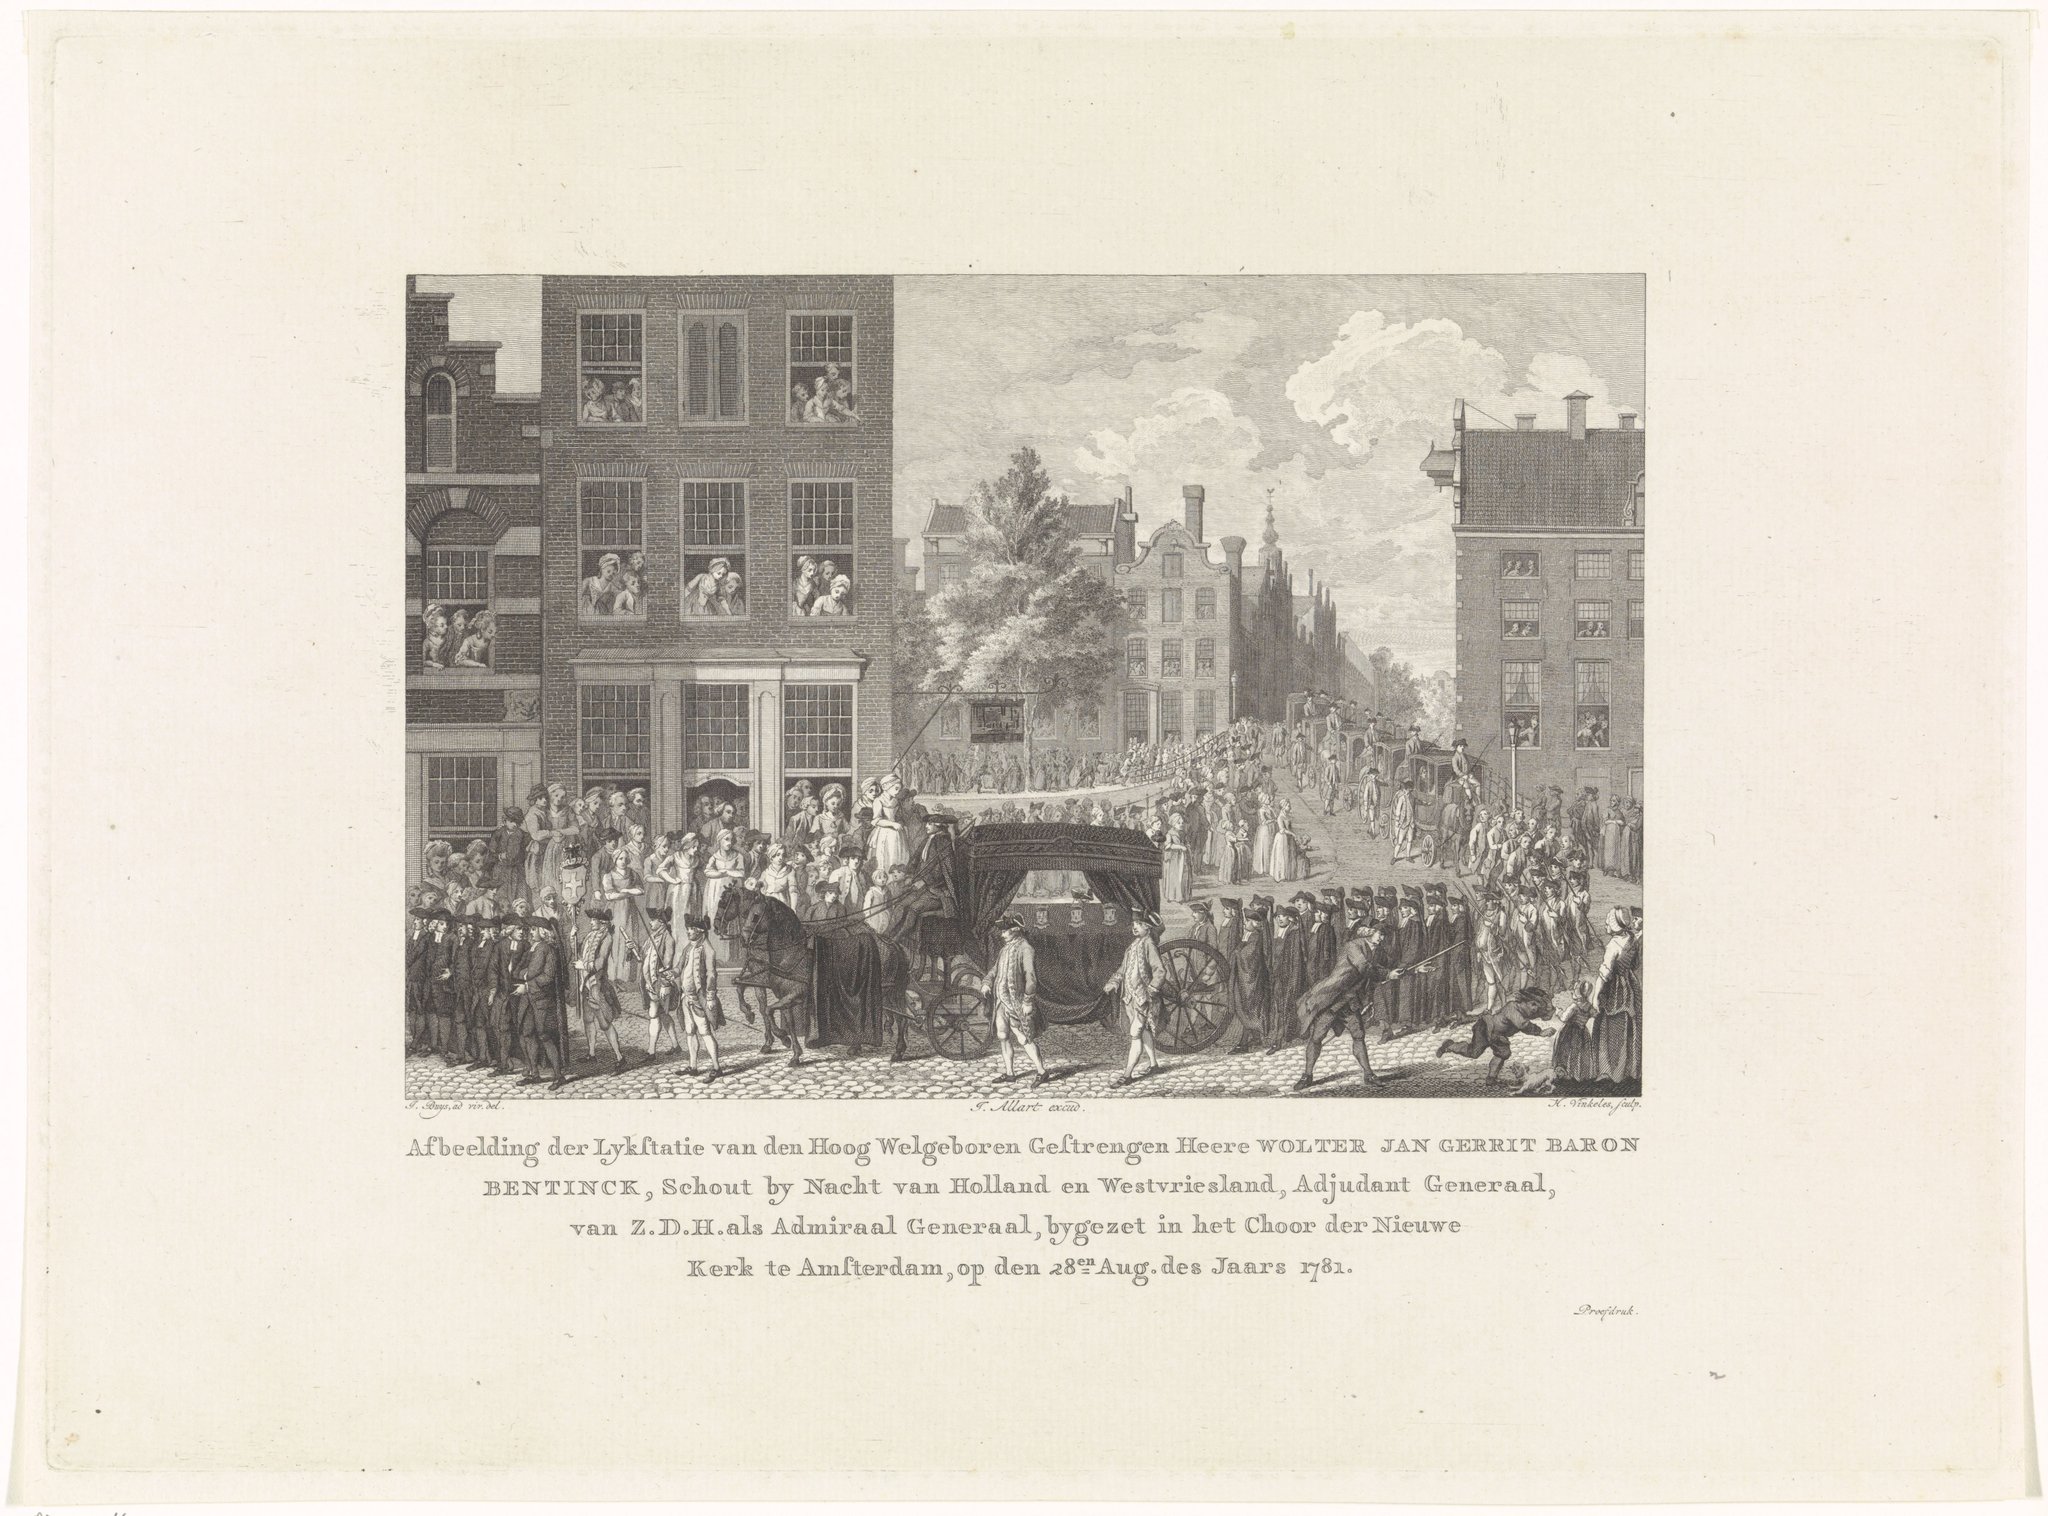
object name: print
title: Lijkstatie van Wolter Jan Gerrit baron Bentinck, 1781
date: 1782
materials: paper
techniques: engraving, etching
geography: amsterdam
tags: amsterdam, funeral carriages, cortege, funeral procession, public funeral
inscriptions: collector's mark: Lugt 2228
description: Latere (derde) staat van deze prent was bestemd voor gebruik als illustratie in: Francq van Berkhey, Johannes le. De zeetriumph der Bataafsche vryheid, op Doggersbank. Bevochten den 5den van Oogstmaand 1781. 2 delen. Amsterdam: Johannes Allart, 1782. De prent was echter niet op tijd klaar om in het boek opgenomen te worden, maar werd alsnog later door de uitgever aan de intekenaren geleverd. Voor eerste bekende staat zie RP-P-OB-85.212. Voor derde bekende staat zie RP-P-AO-28-110. Voor vierde bekende staat zie RP-P-1944-1923.